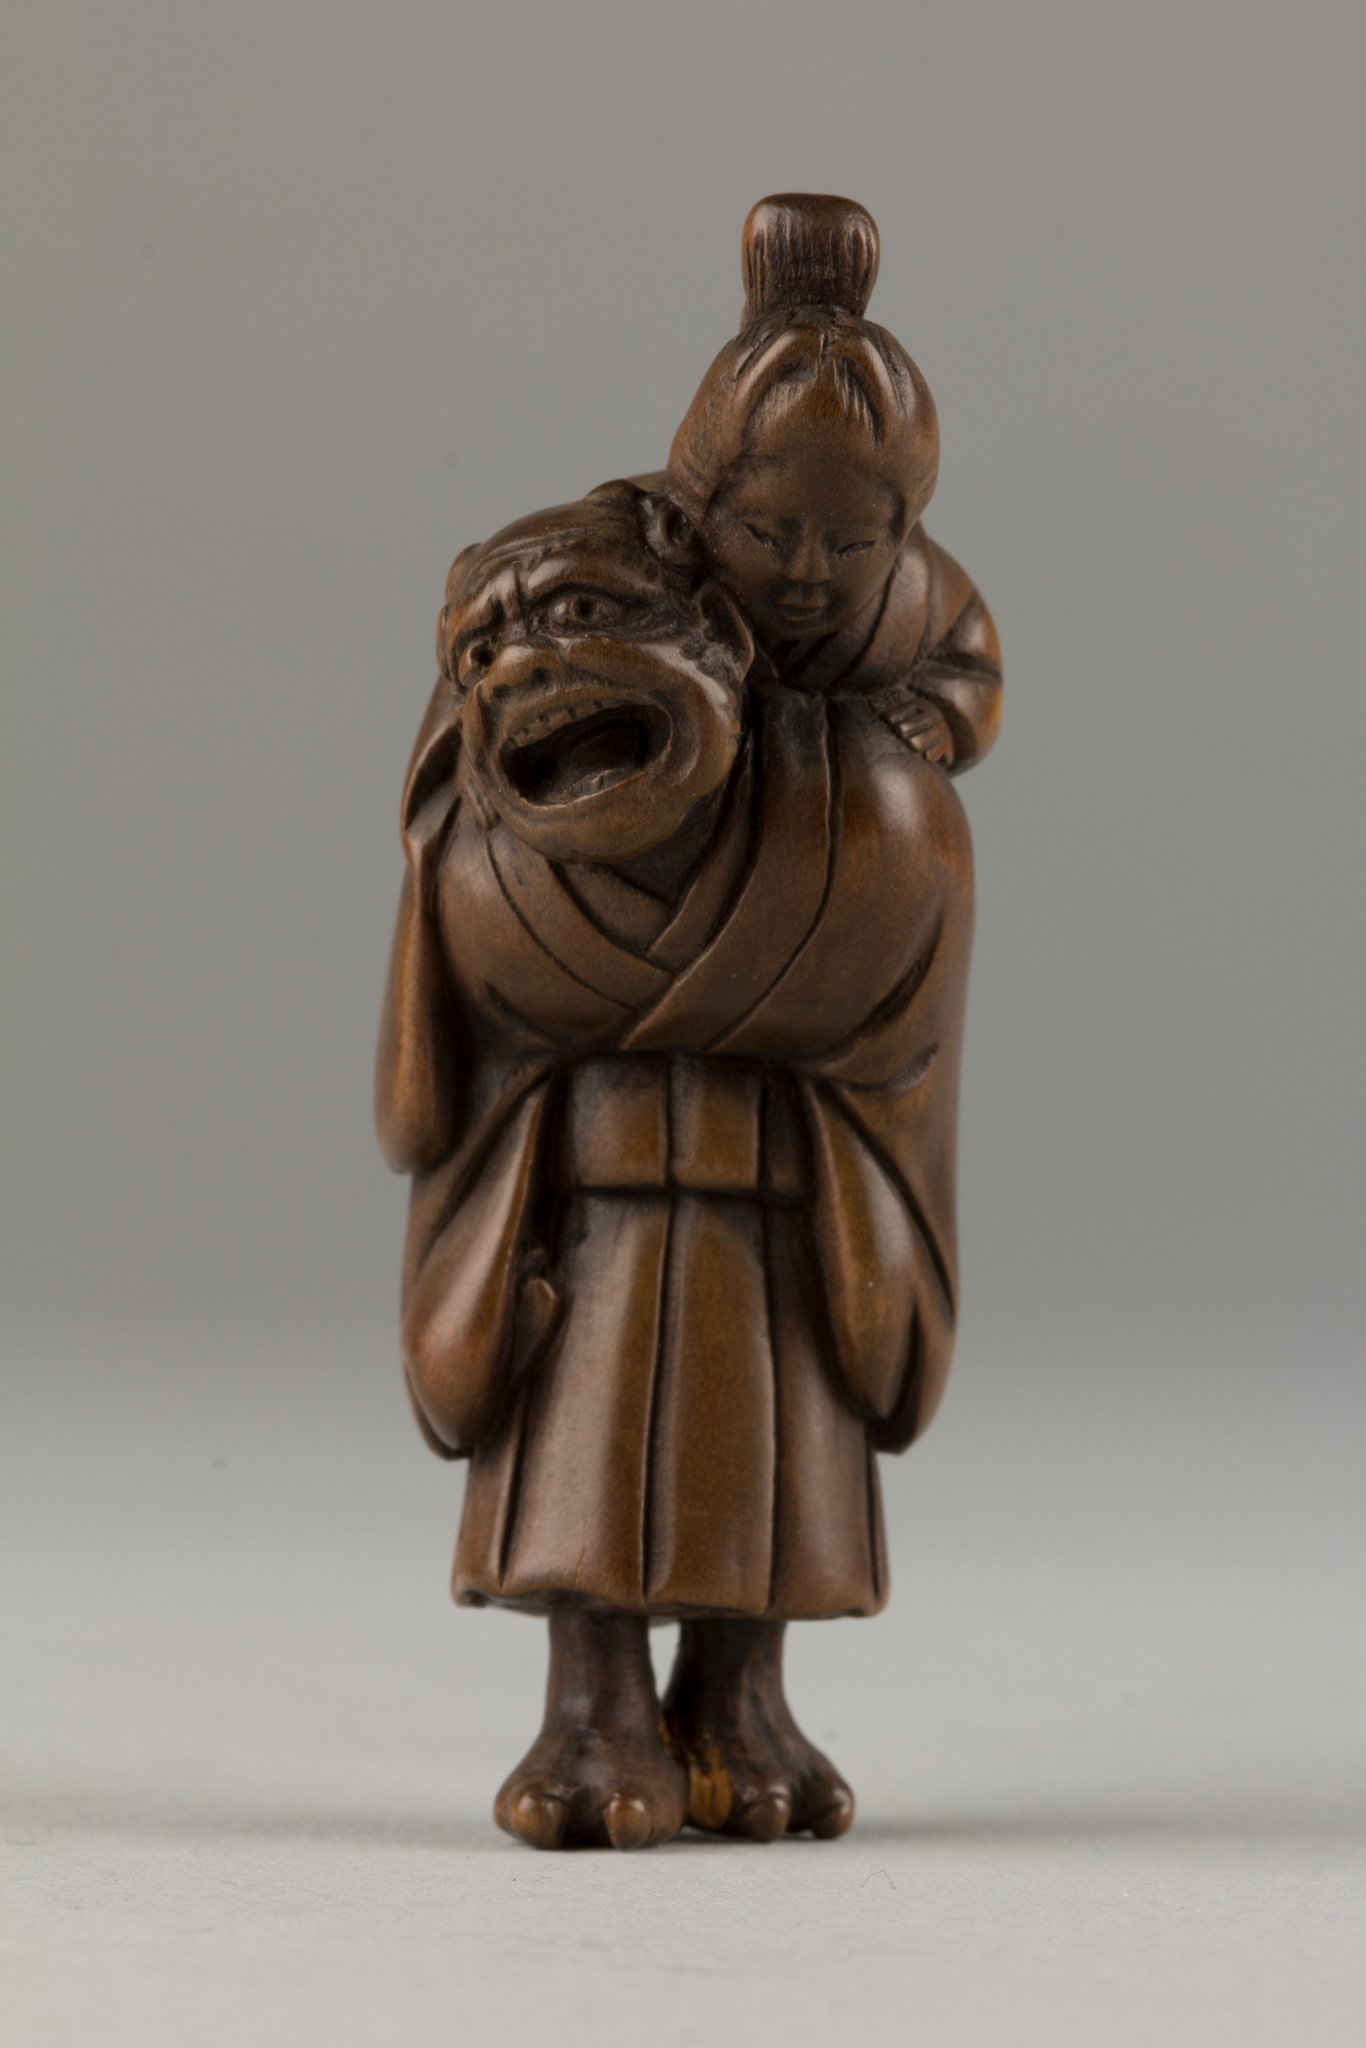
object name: netsuke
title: Netsuke of Demon Carrying a Woman on His Shoulders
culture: japanese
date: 1801-1900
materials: wood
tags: women,demons